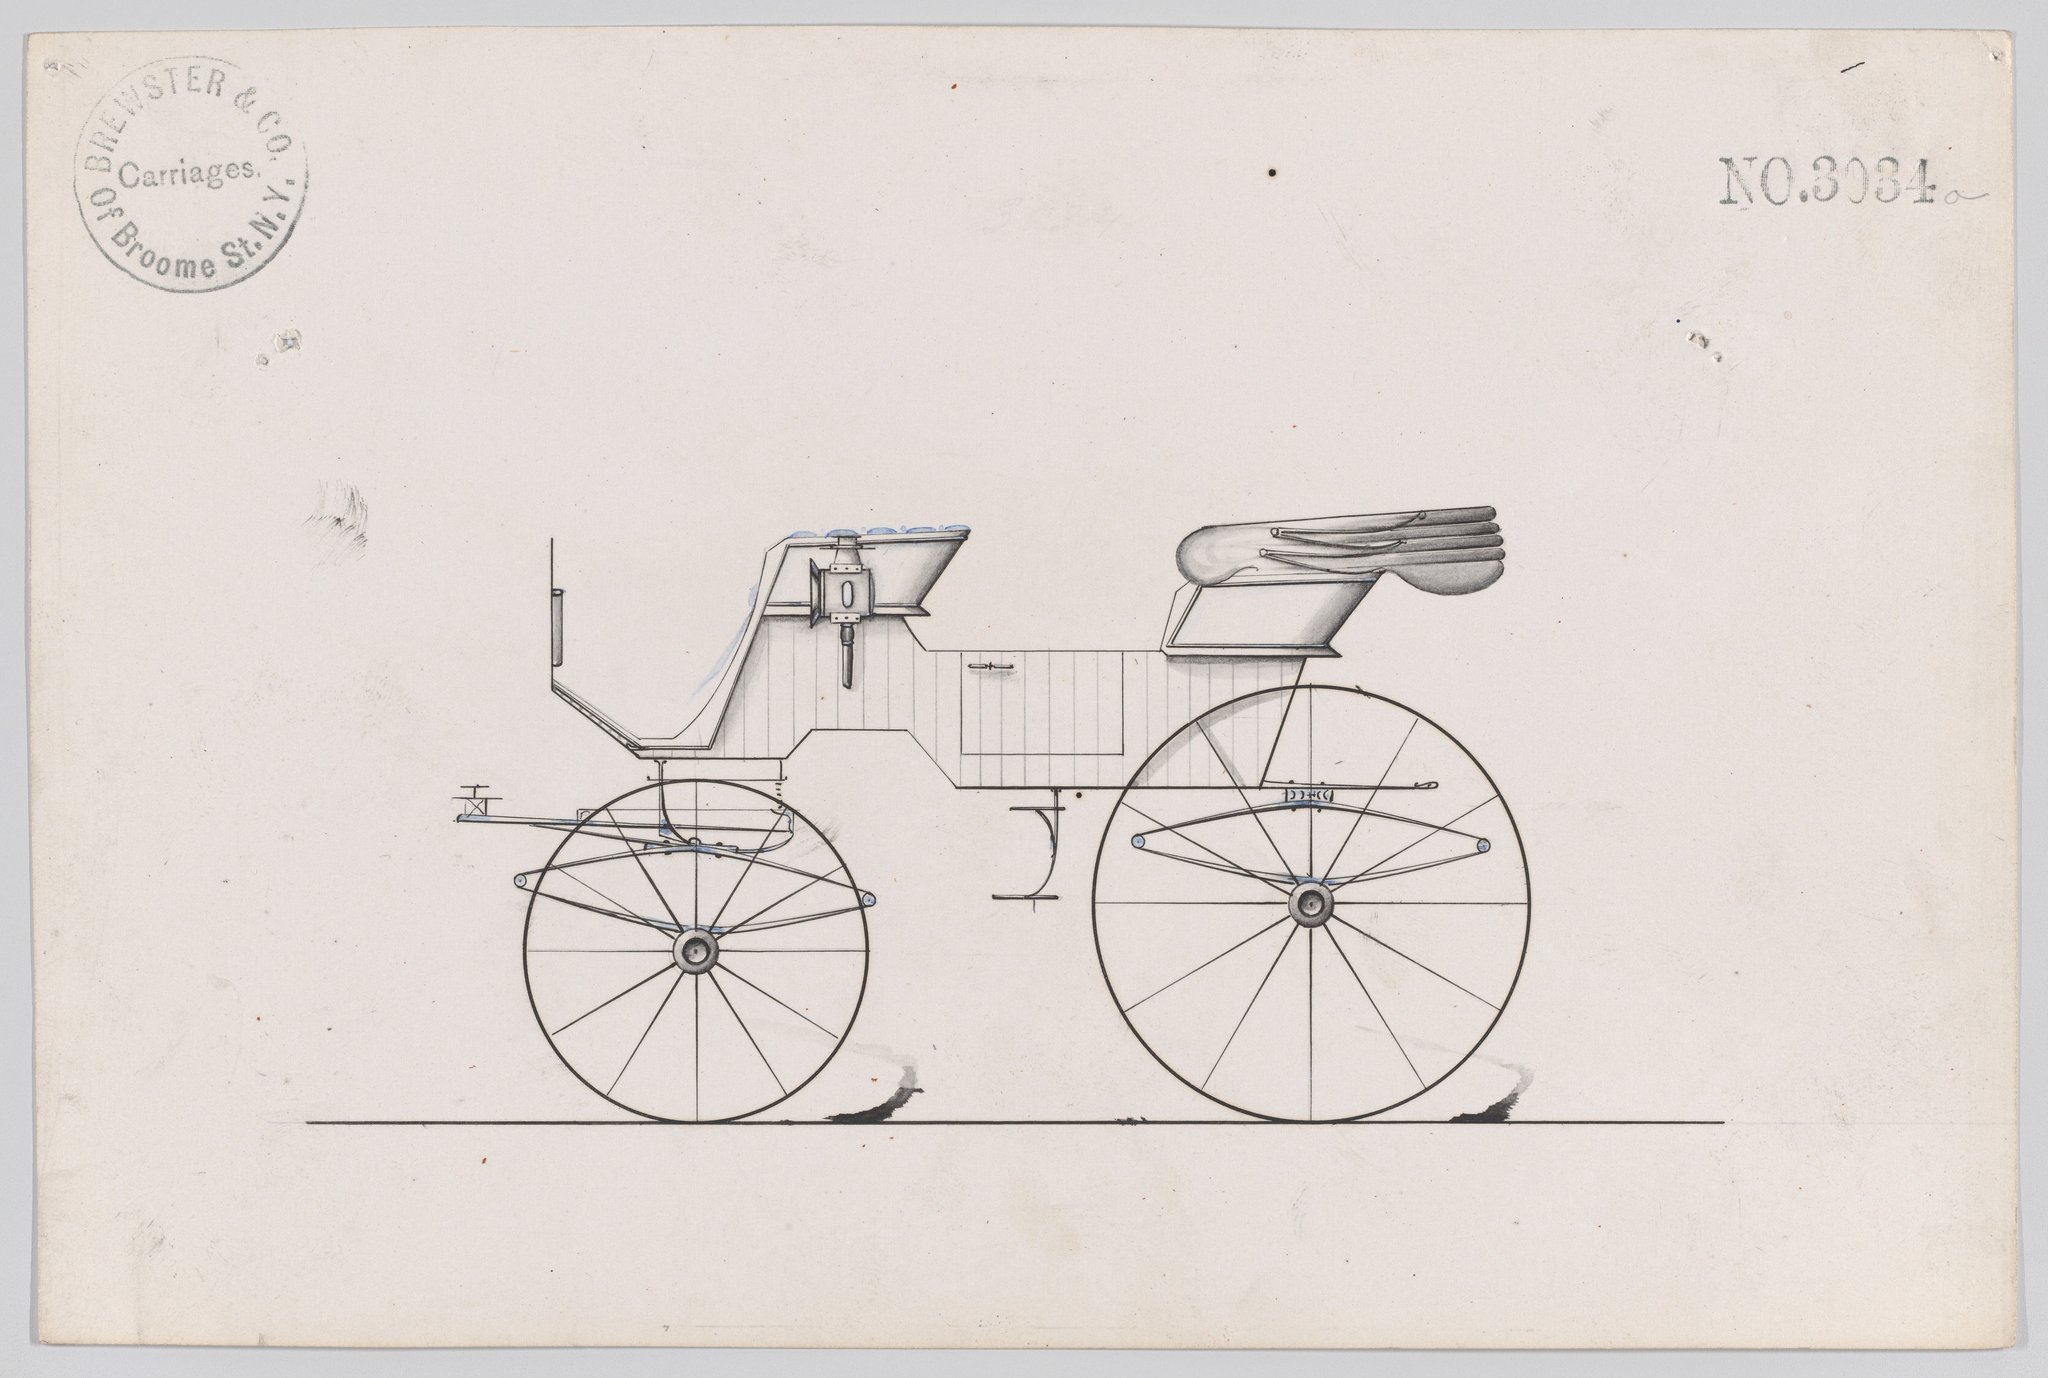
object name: drawing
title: Design for 4 seat Phaeton, no. 3034a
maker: brewster & co.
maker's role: manufacturer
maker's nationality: american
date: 1874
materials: gouache, ink, watercolor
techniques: pen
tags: carriages